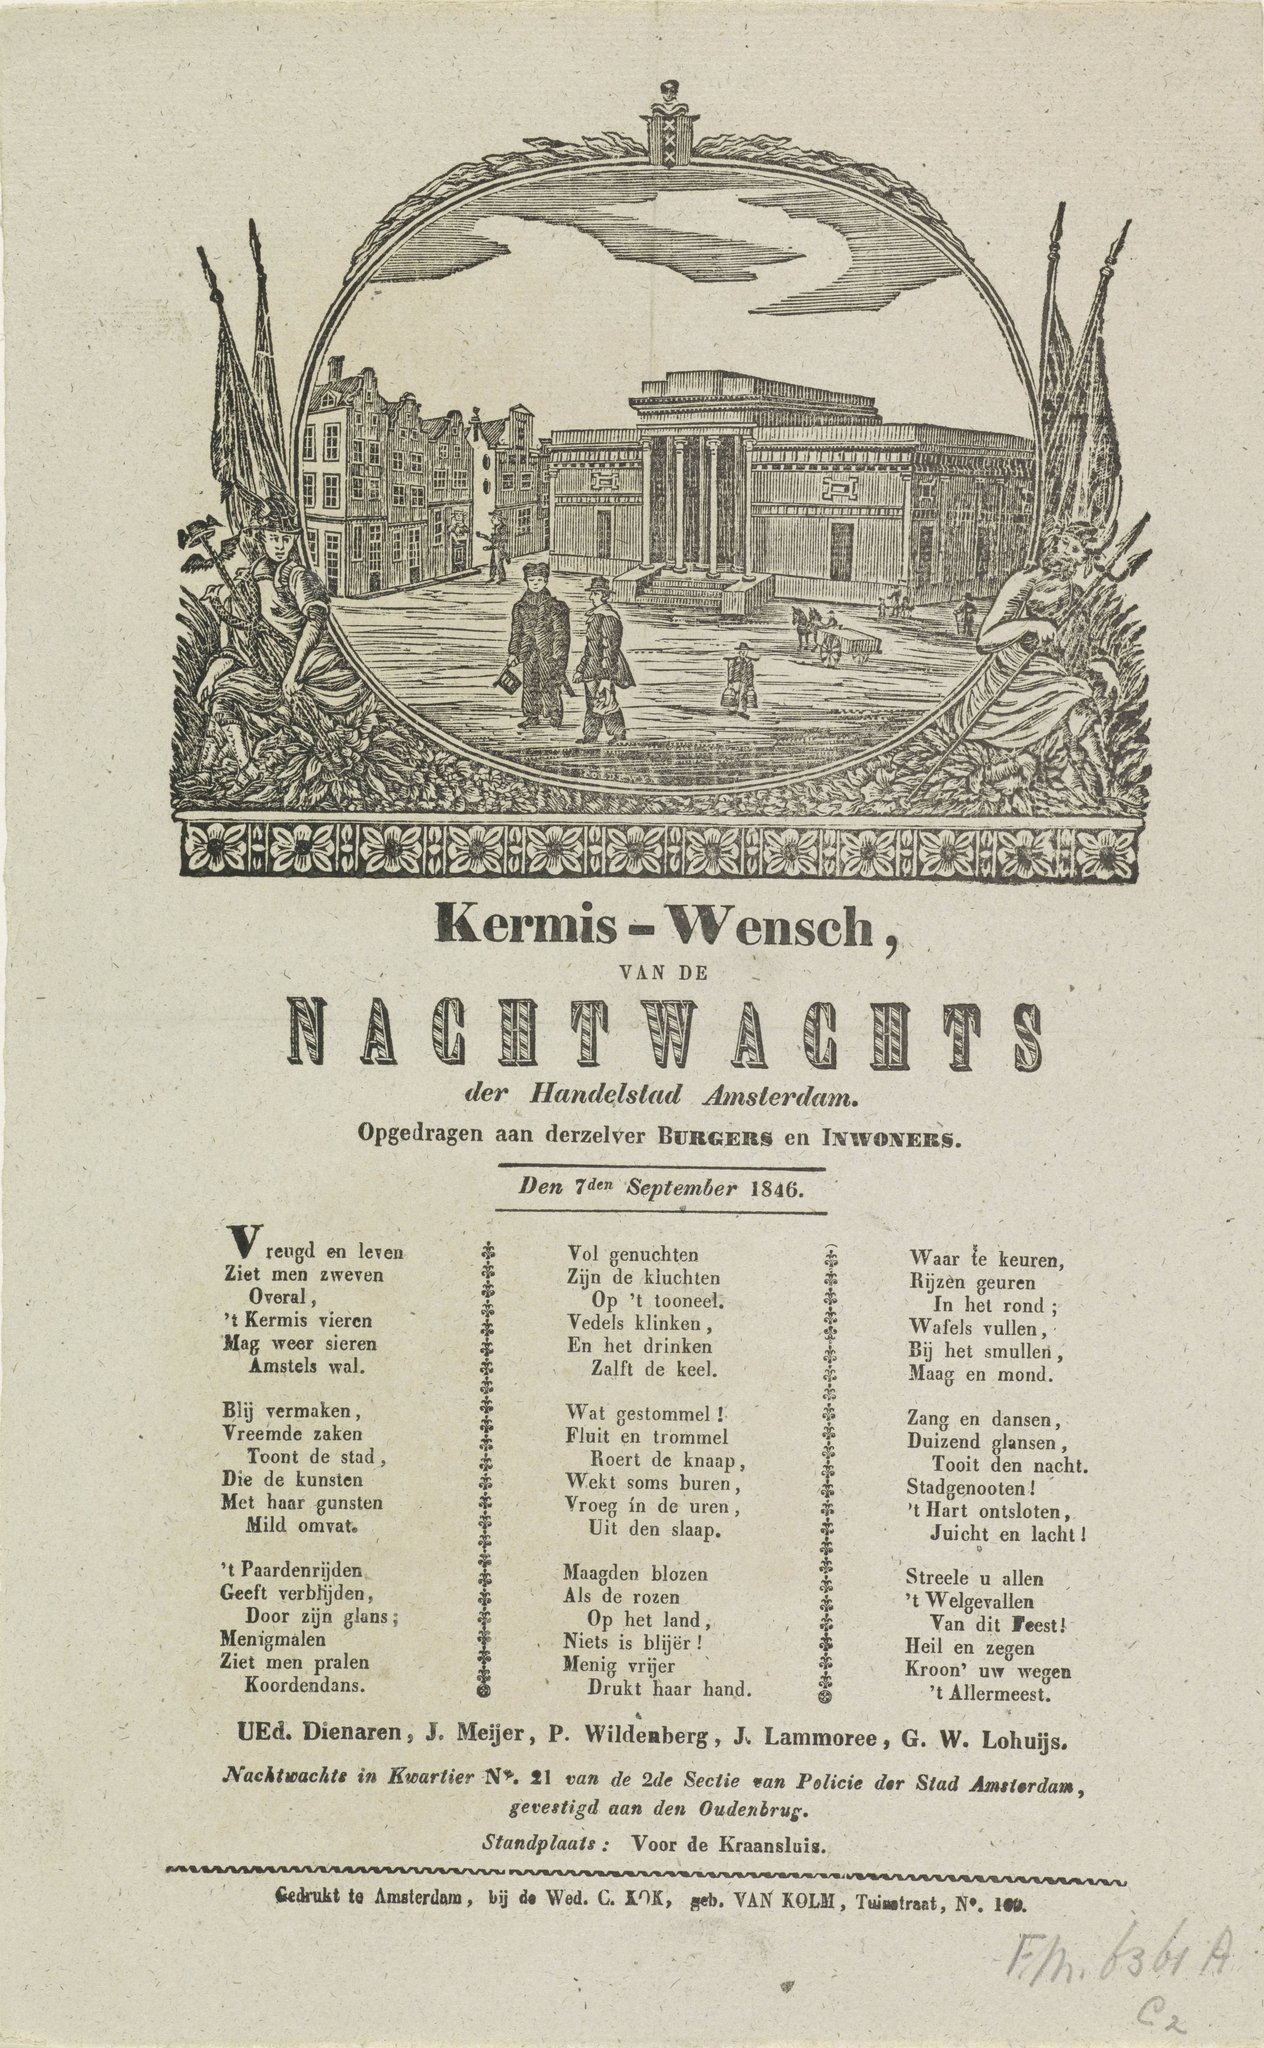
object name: fair print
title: Kermisprent van de Amsterdamse nachtwacht voor het jaar 1846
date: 1846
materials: paper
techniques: letterpress printing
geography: amsterdam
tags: night patrol, amsterdam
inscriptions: collector's mark: Lugt 2228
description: Kermisprent van de Amsterdamse nachtwacht (ratelwacht), 7 september 1846. Enkele mannen lopen 's nachts met ratels door een straat voor de Beurs van Zocher. Ovale voorstelling met links de Vrijheid en rechts een riviergod. Met een vers in drie kolommen. Namens de nachtwacht in kwartier No. 21 van de 2e sectie van Politie: J. Meijer, P. Wildenberg, J. Lammoree en G.W. Lohuijs.